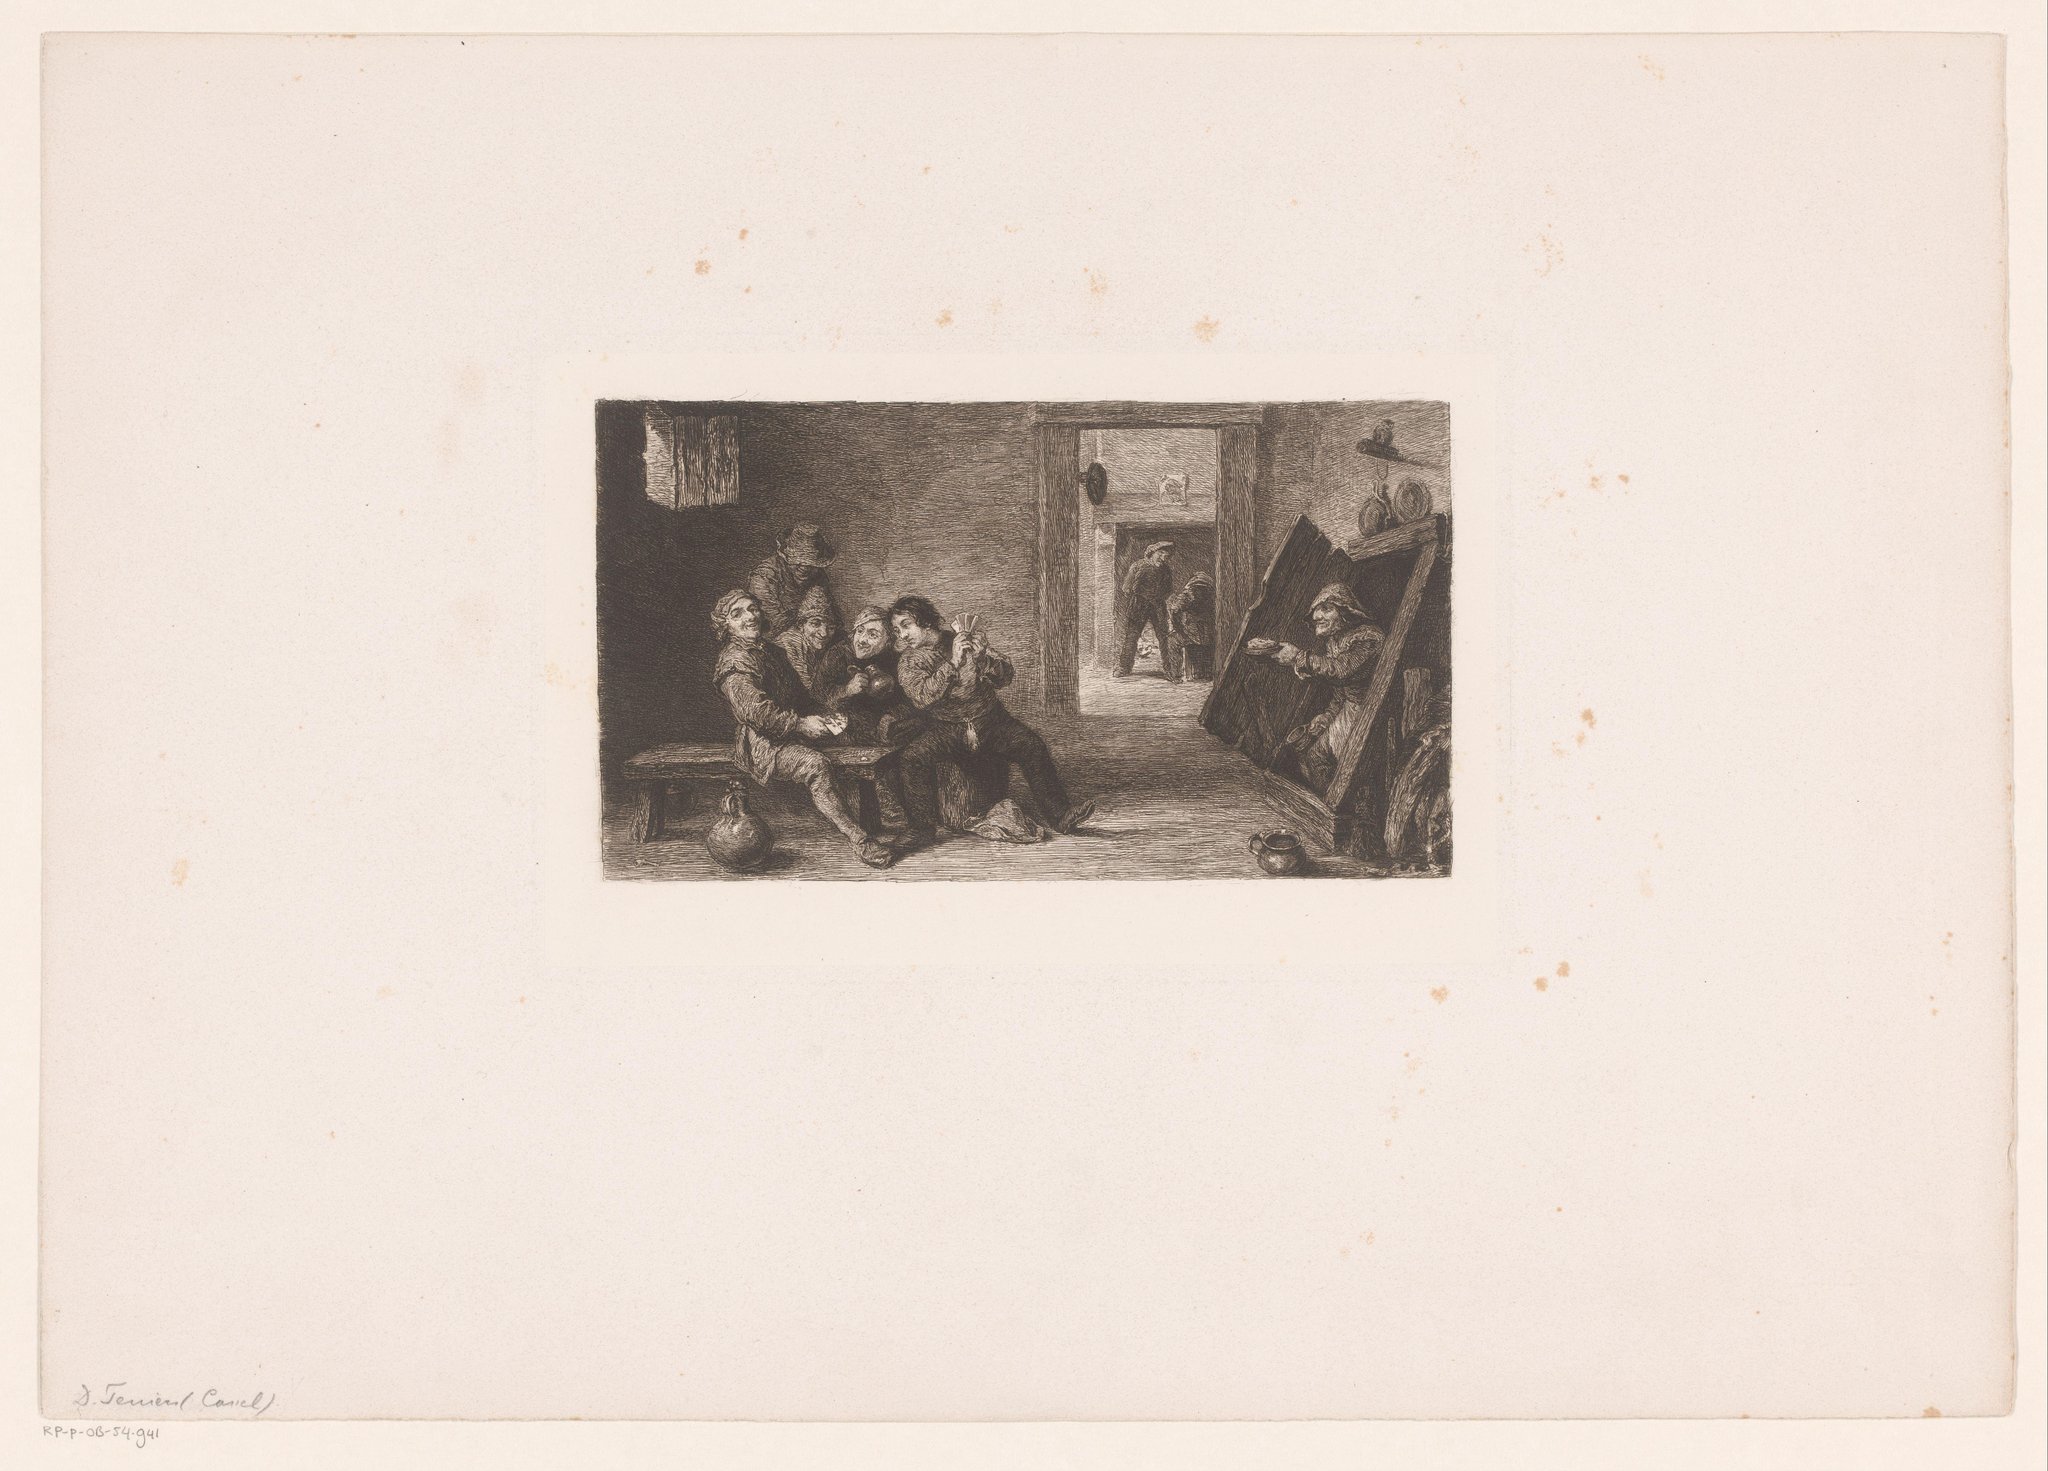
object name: print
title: Kaartspelende boeren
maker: william unger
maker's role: draughtsman, painter, print maker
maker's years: 1837-1932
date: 1847-1932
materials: paper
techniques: etching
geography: germany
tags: playing-cards, alcoholic drinks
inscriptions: collector's mark: Lugt 2228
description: Prent naar het schilderij door David Teniers in de Gemäldegalerie Alte Meister te Kassel (inv.nr. GK 139).